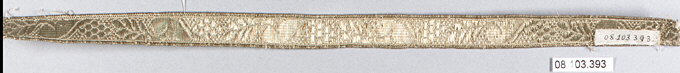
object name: galloon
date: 1601-1800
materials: metal thread